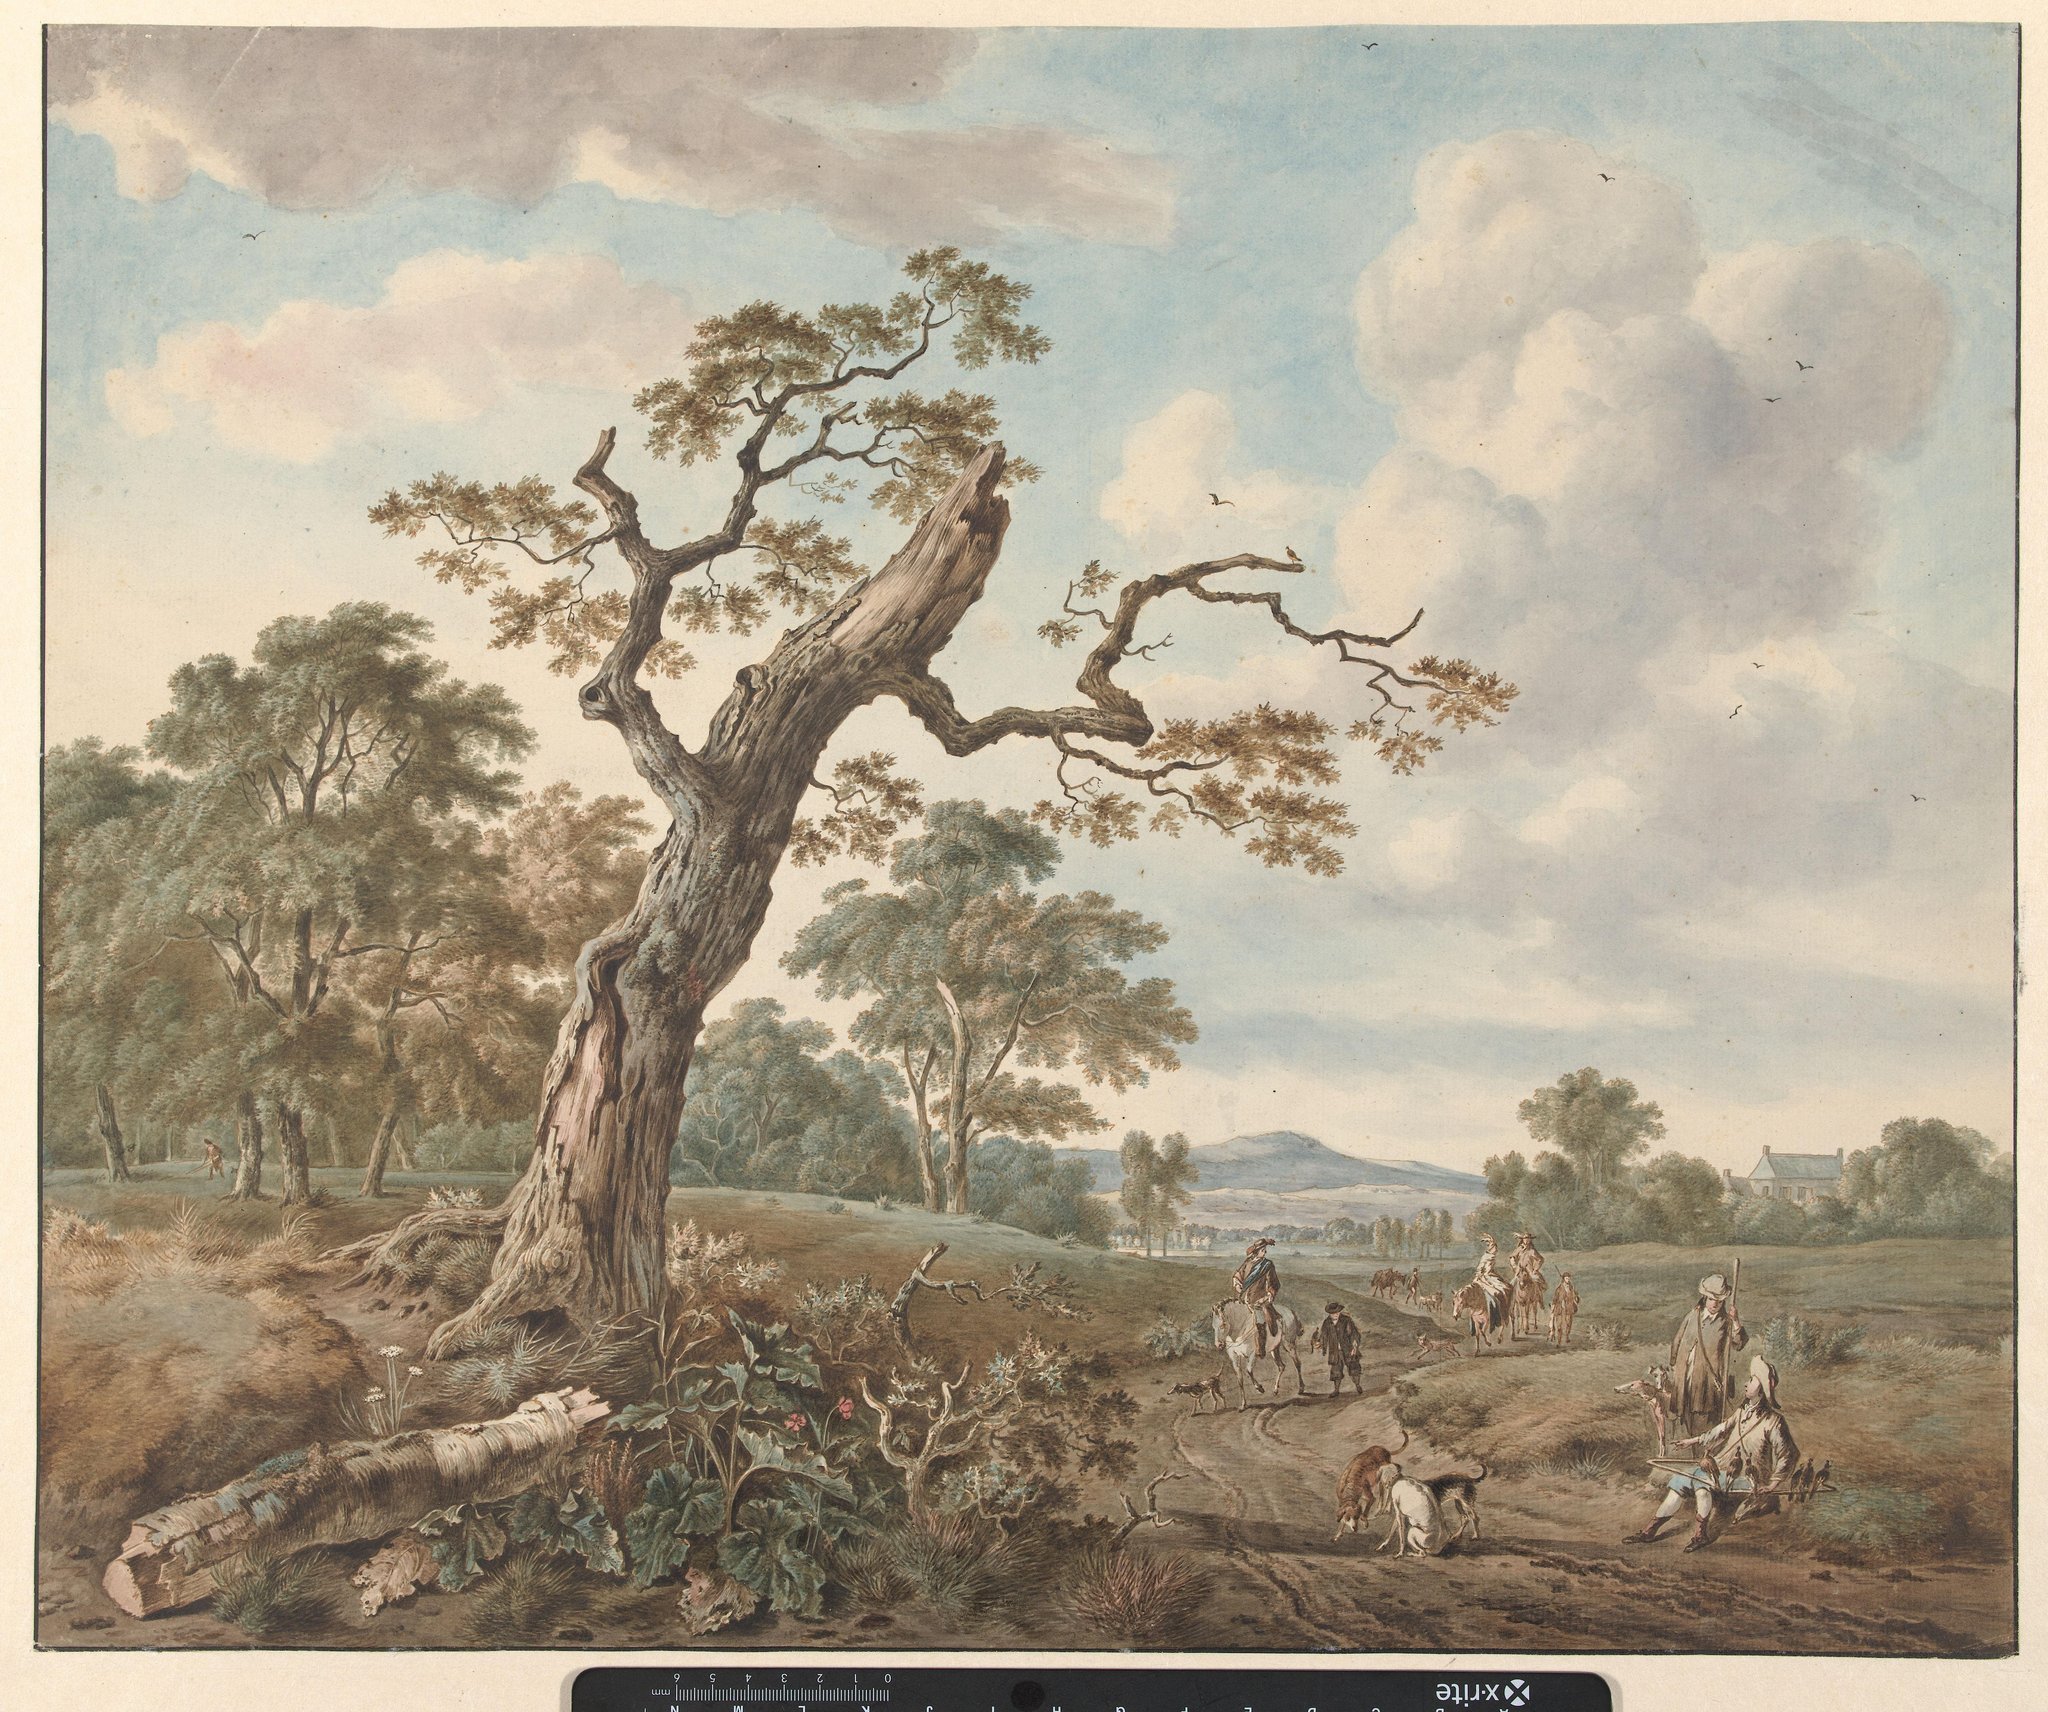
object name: drawing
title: Landschap met jachtgezelschap op een landweg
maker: gerard van nijmegen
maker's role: draughtsman, painter, print maker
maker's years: 1735-1808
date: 1786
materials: ink, paper, watercolor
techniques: brush, pen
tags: bird hunting (+ hunting with falcon, hawk; falconry)